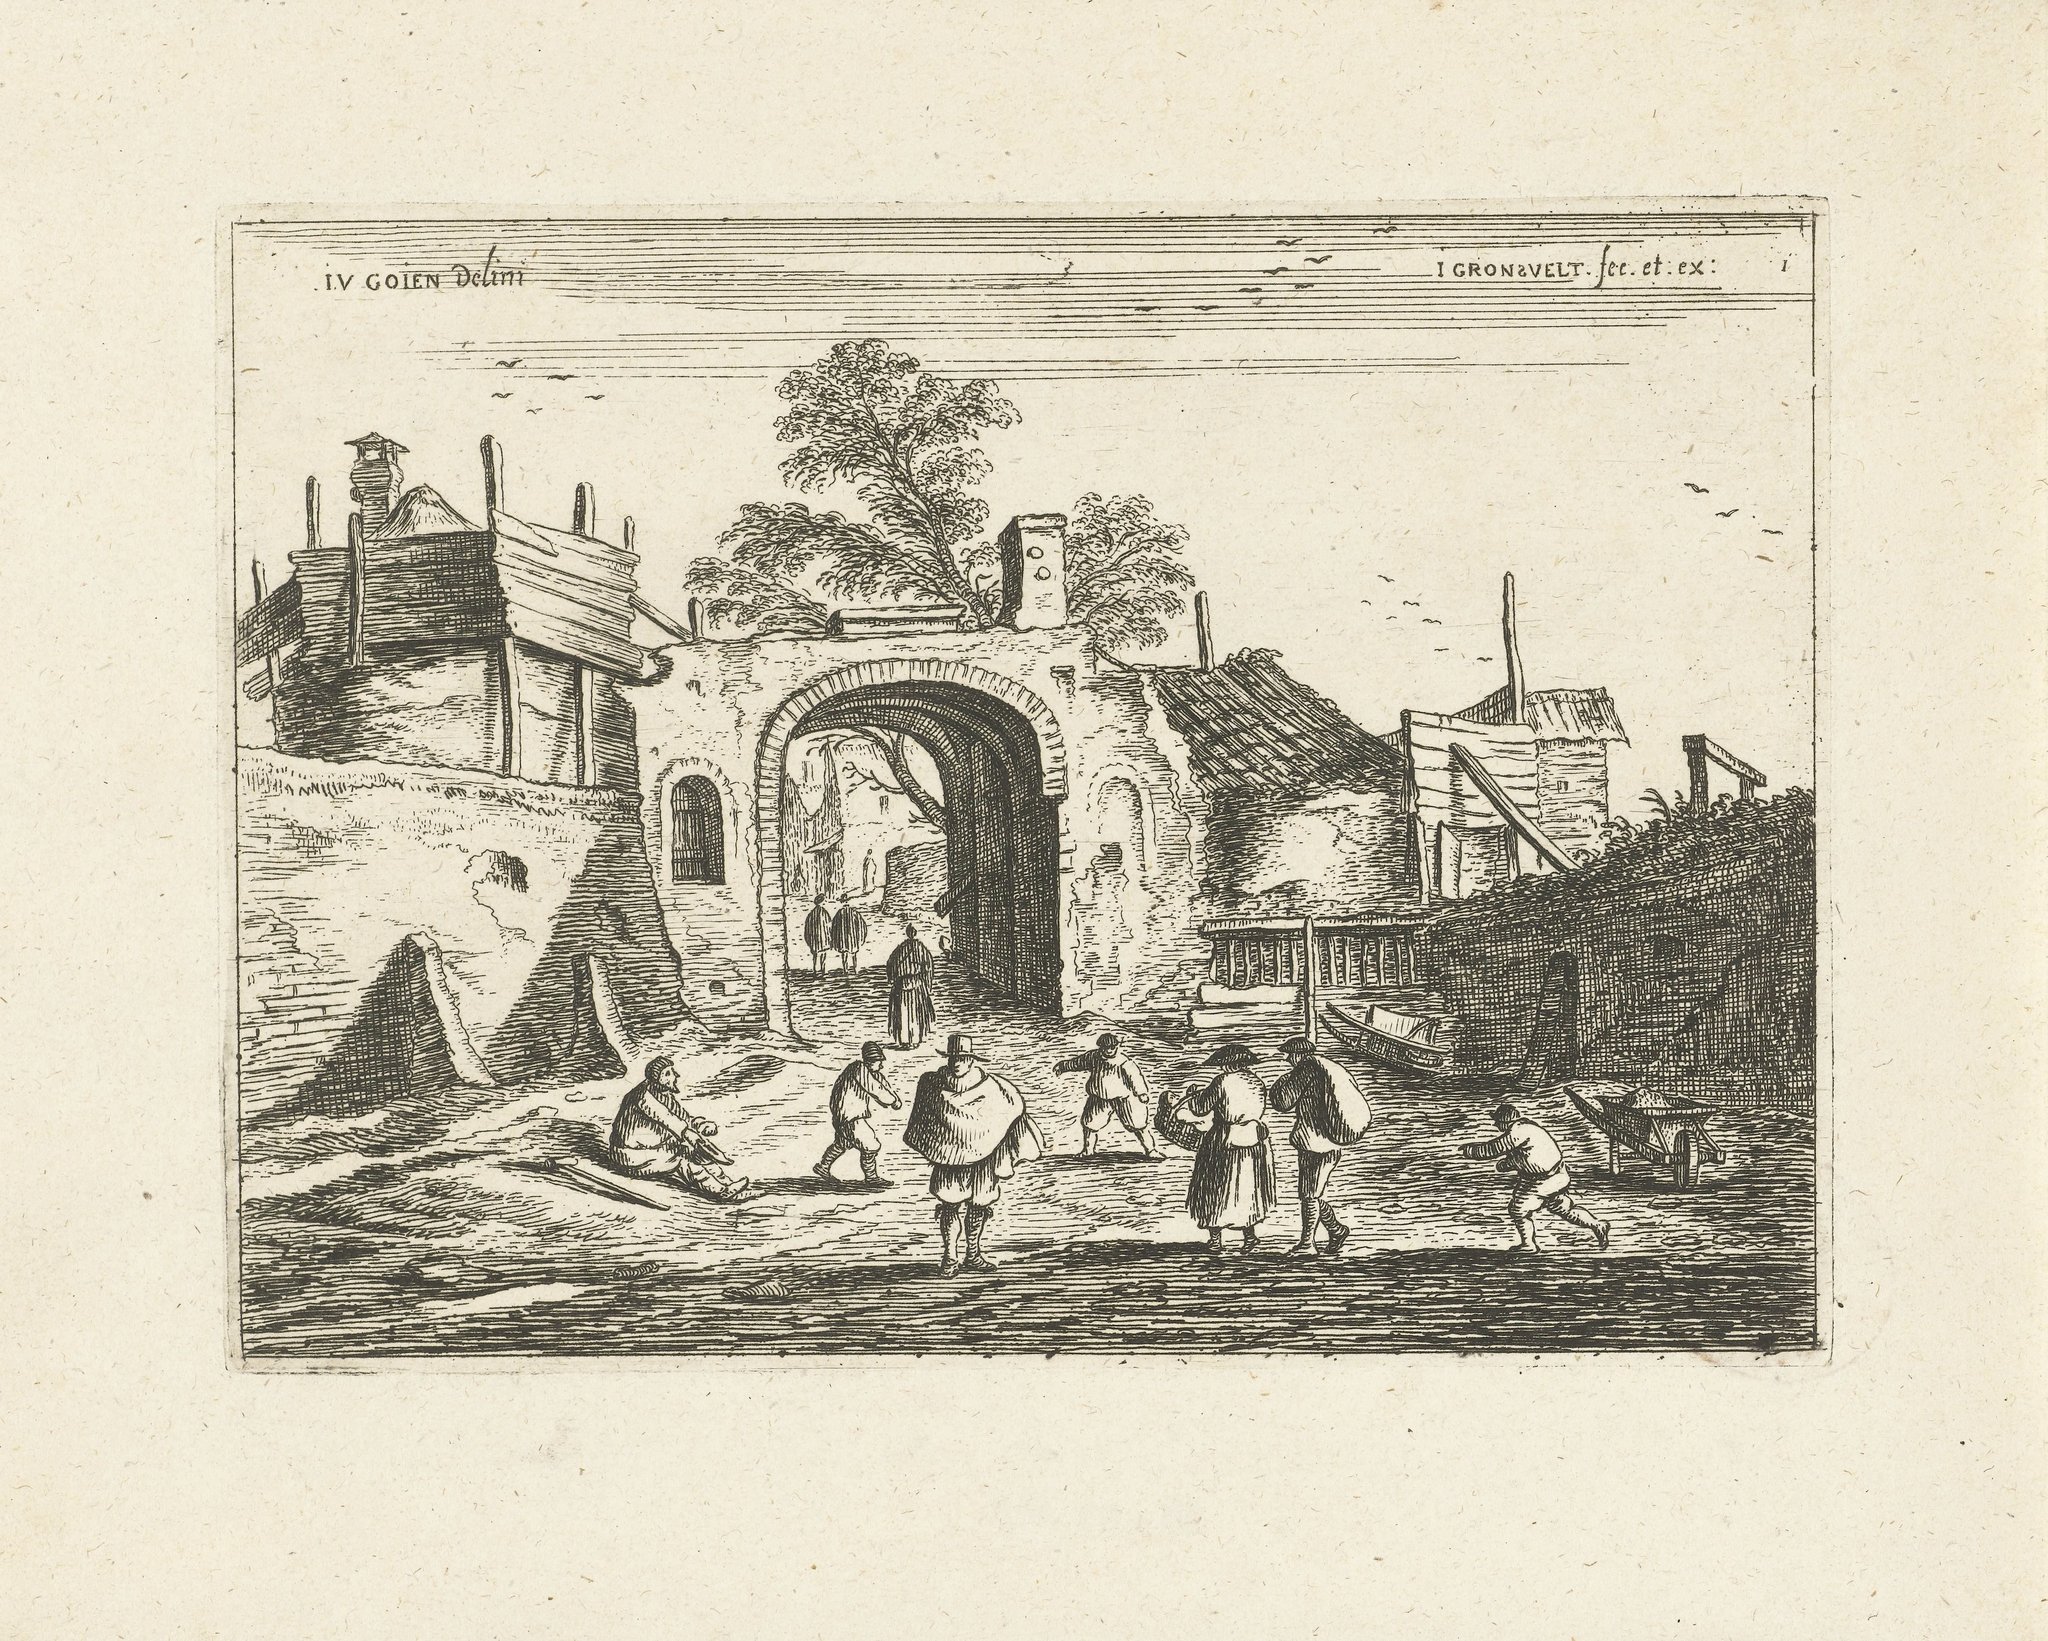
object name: titelprent, frontispice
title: Gezicht op stadspoort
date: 1679-1728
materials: paper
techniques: etching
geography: amsterdam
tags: city-gate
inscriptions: collector's mark: Lugt 240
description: Gezicht op stadspoort met op de voorgrond wandelende figuren, links een bedelaar en rechts een kruiwagen. Eerste prent uit een serie van acht met landschappen.